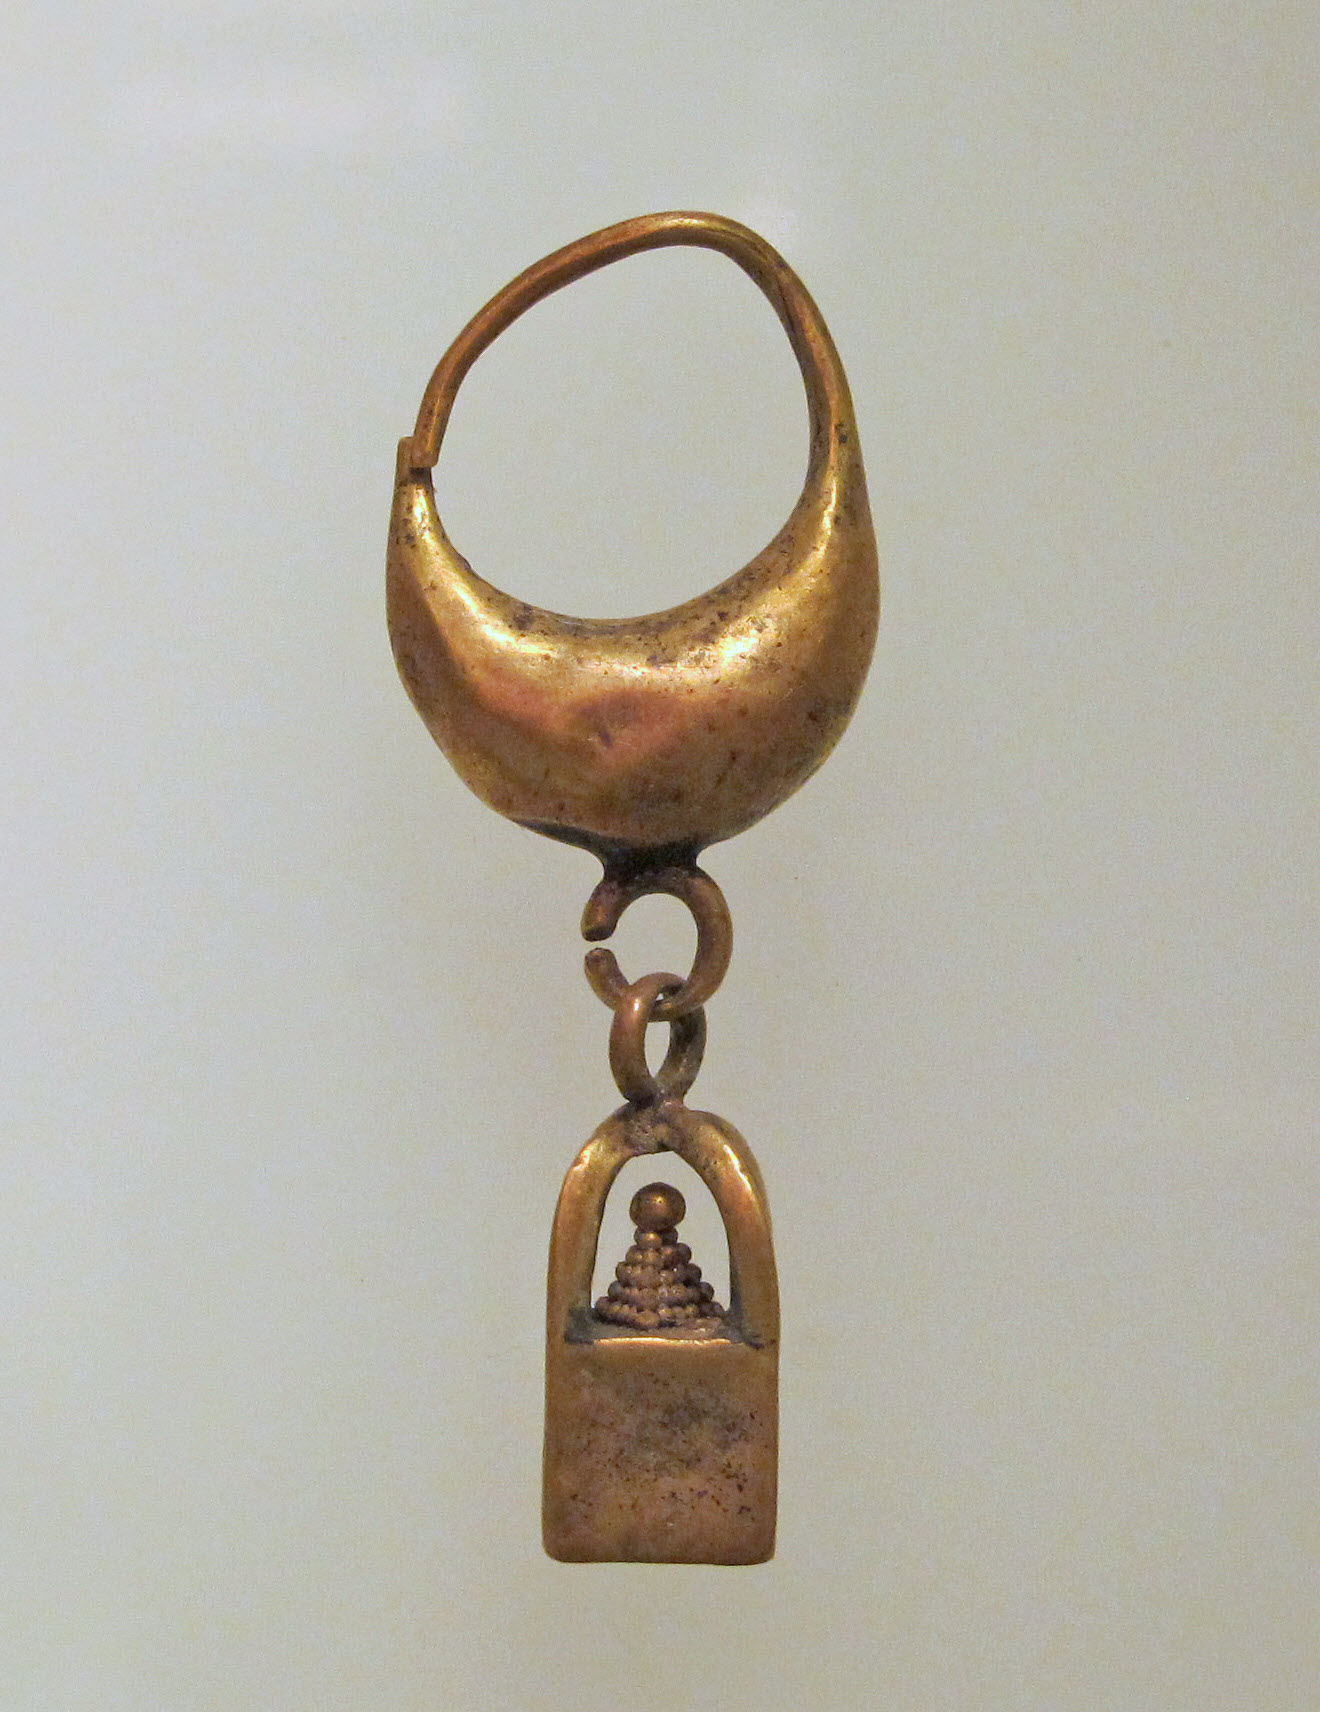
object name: earring with leech and box pendant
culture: cypriot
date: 700-501 BCE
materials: gold